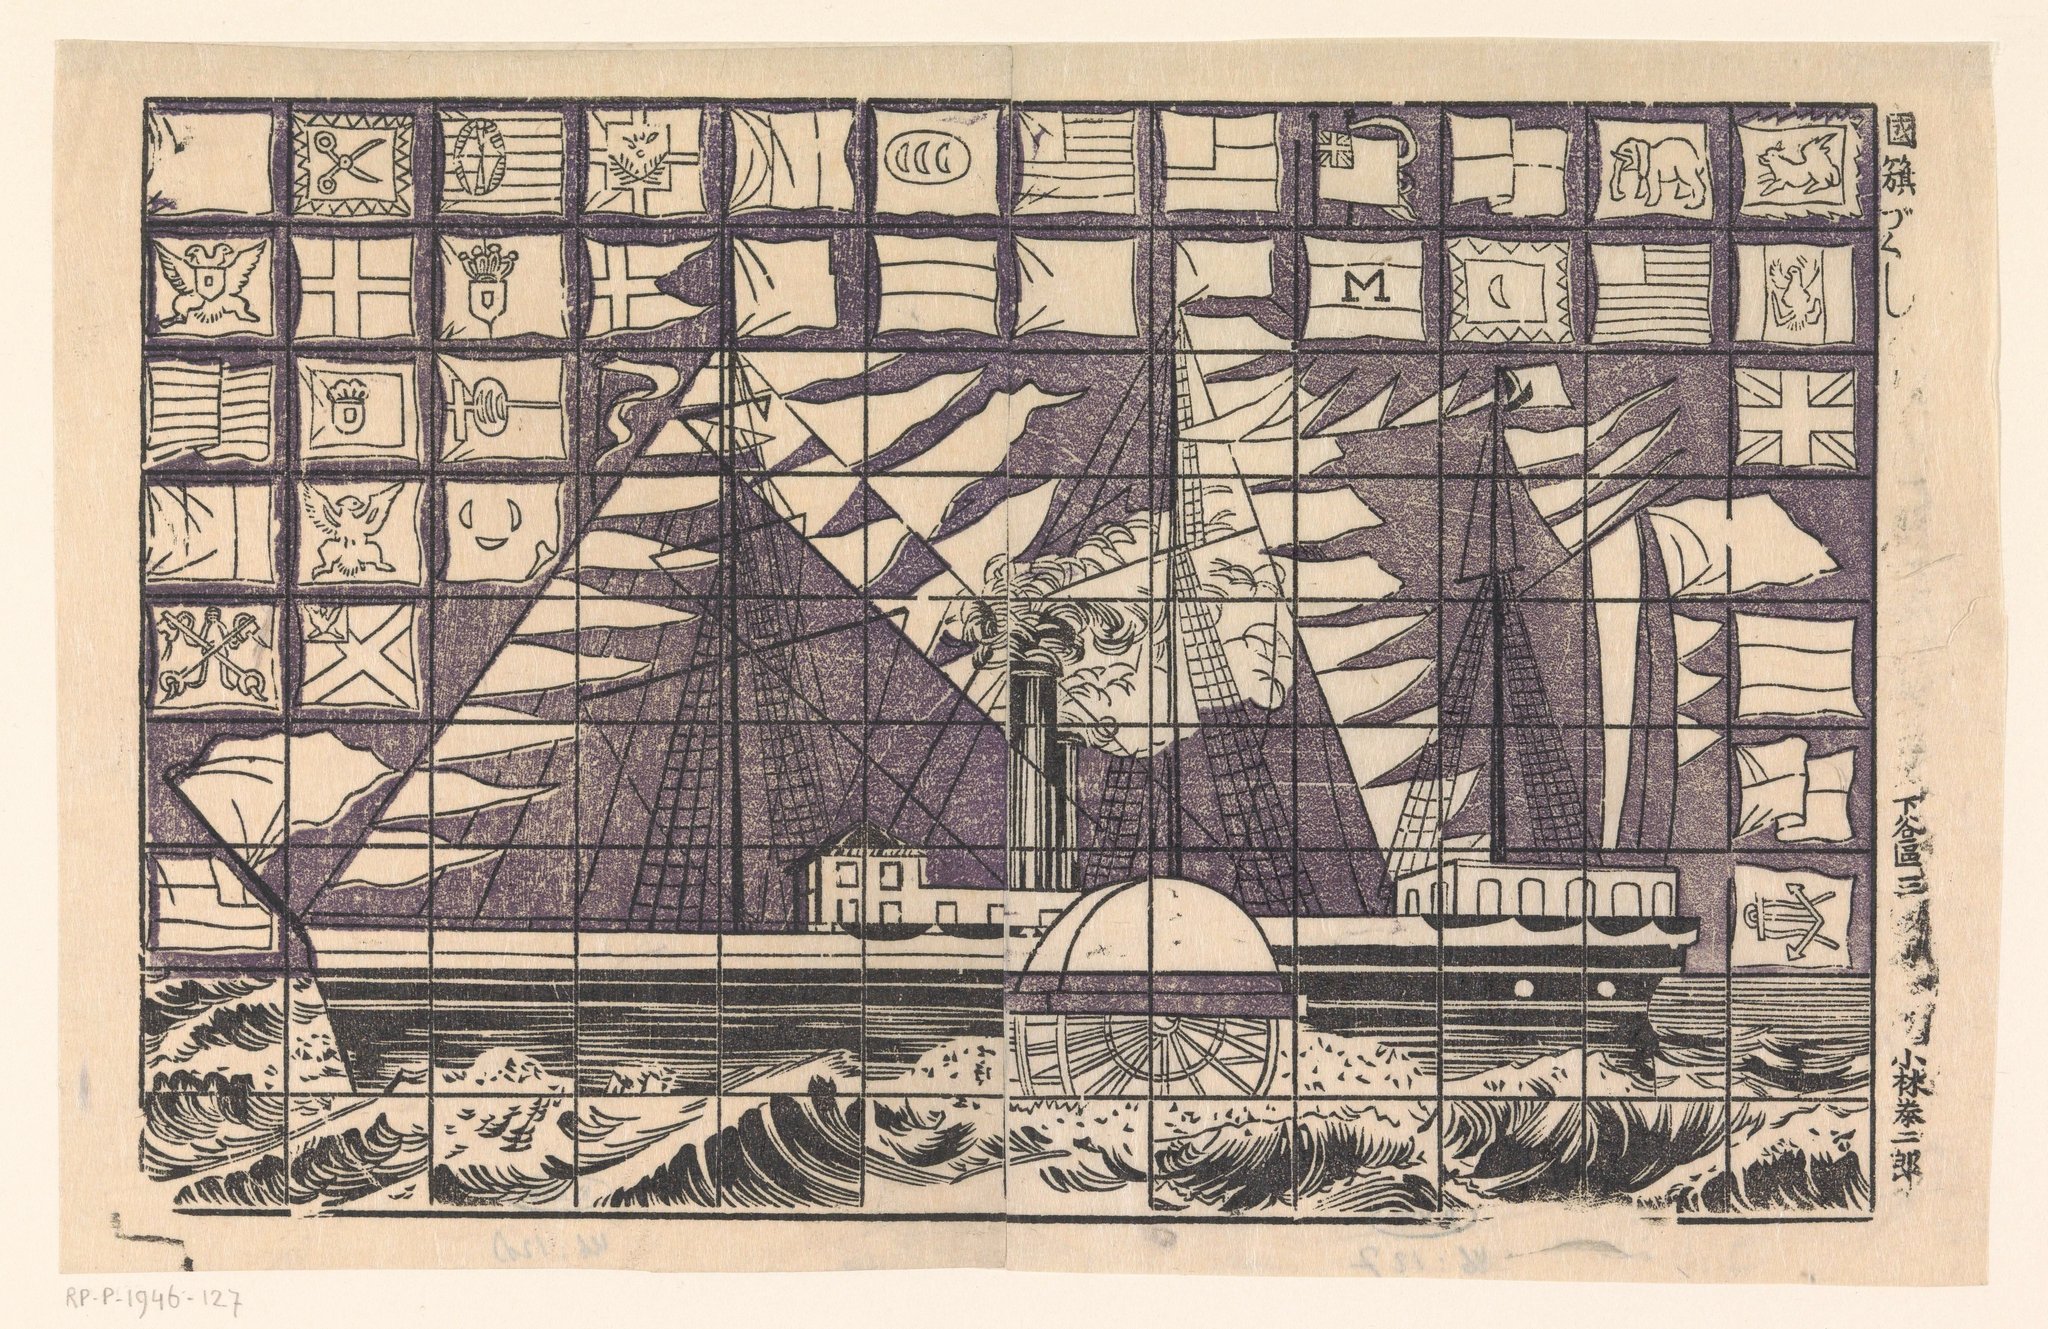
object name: print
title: Raderboot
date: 1883-1942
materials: paper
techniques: woodcut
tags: flag, colours (as symbol of the state, etc.), paddle-wheel boat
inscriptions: collector's mark: Lugt 2228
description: Raderboot met vlaggen achter een raster. Bovenaan zijn de vlakken van het raster gevuld met vlaggen van verschillende landen. Rechts Japanse karakters.